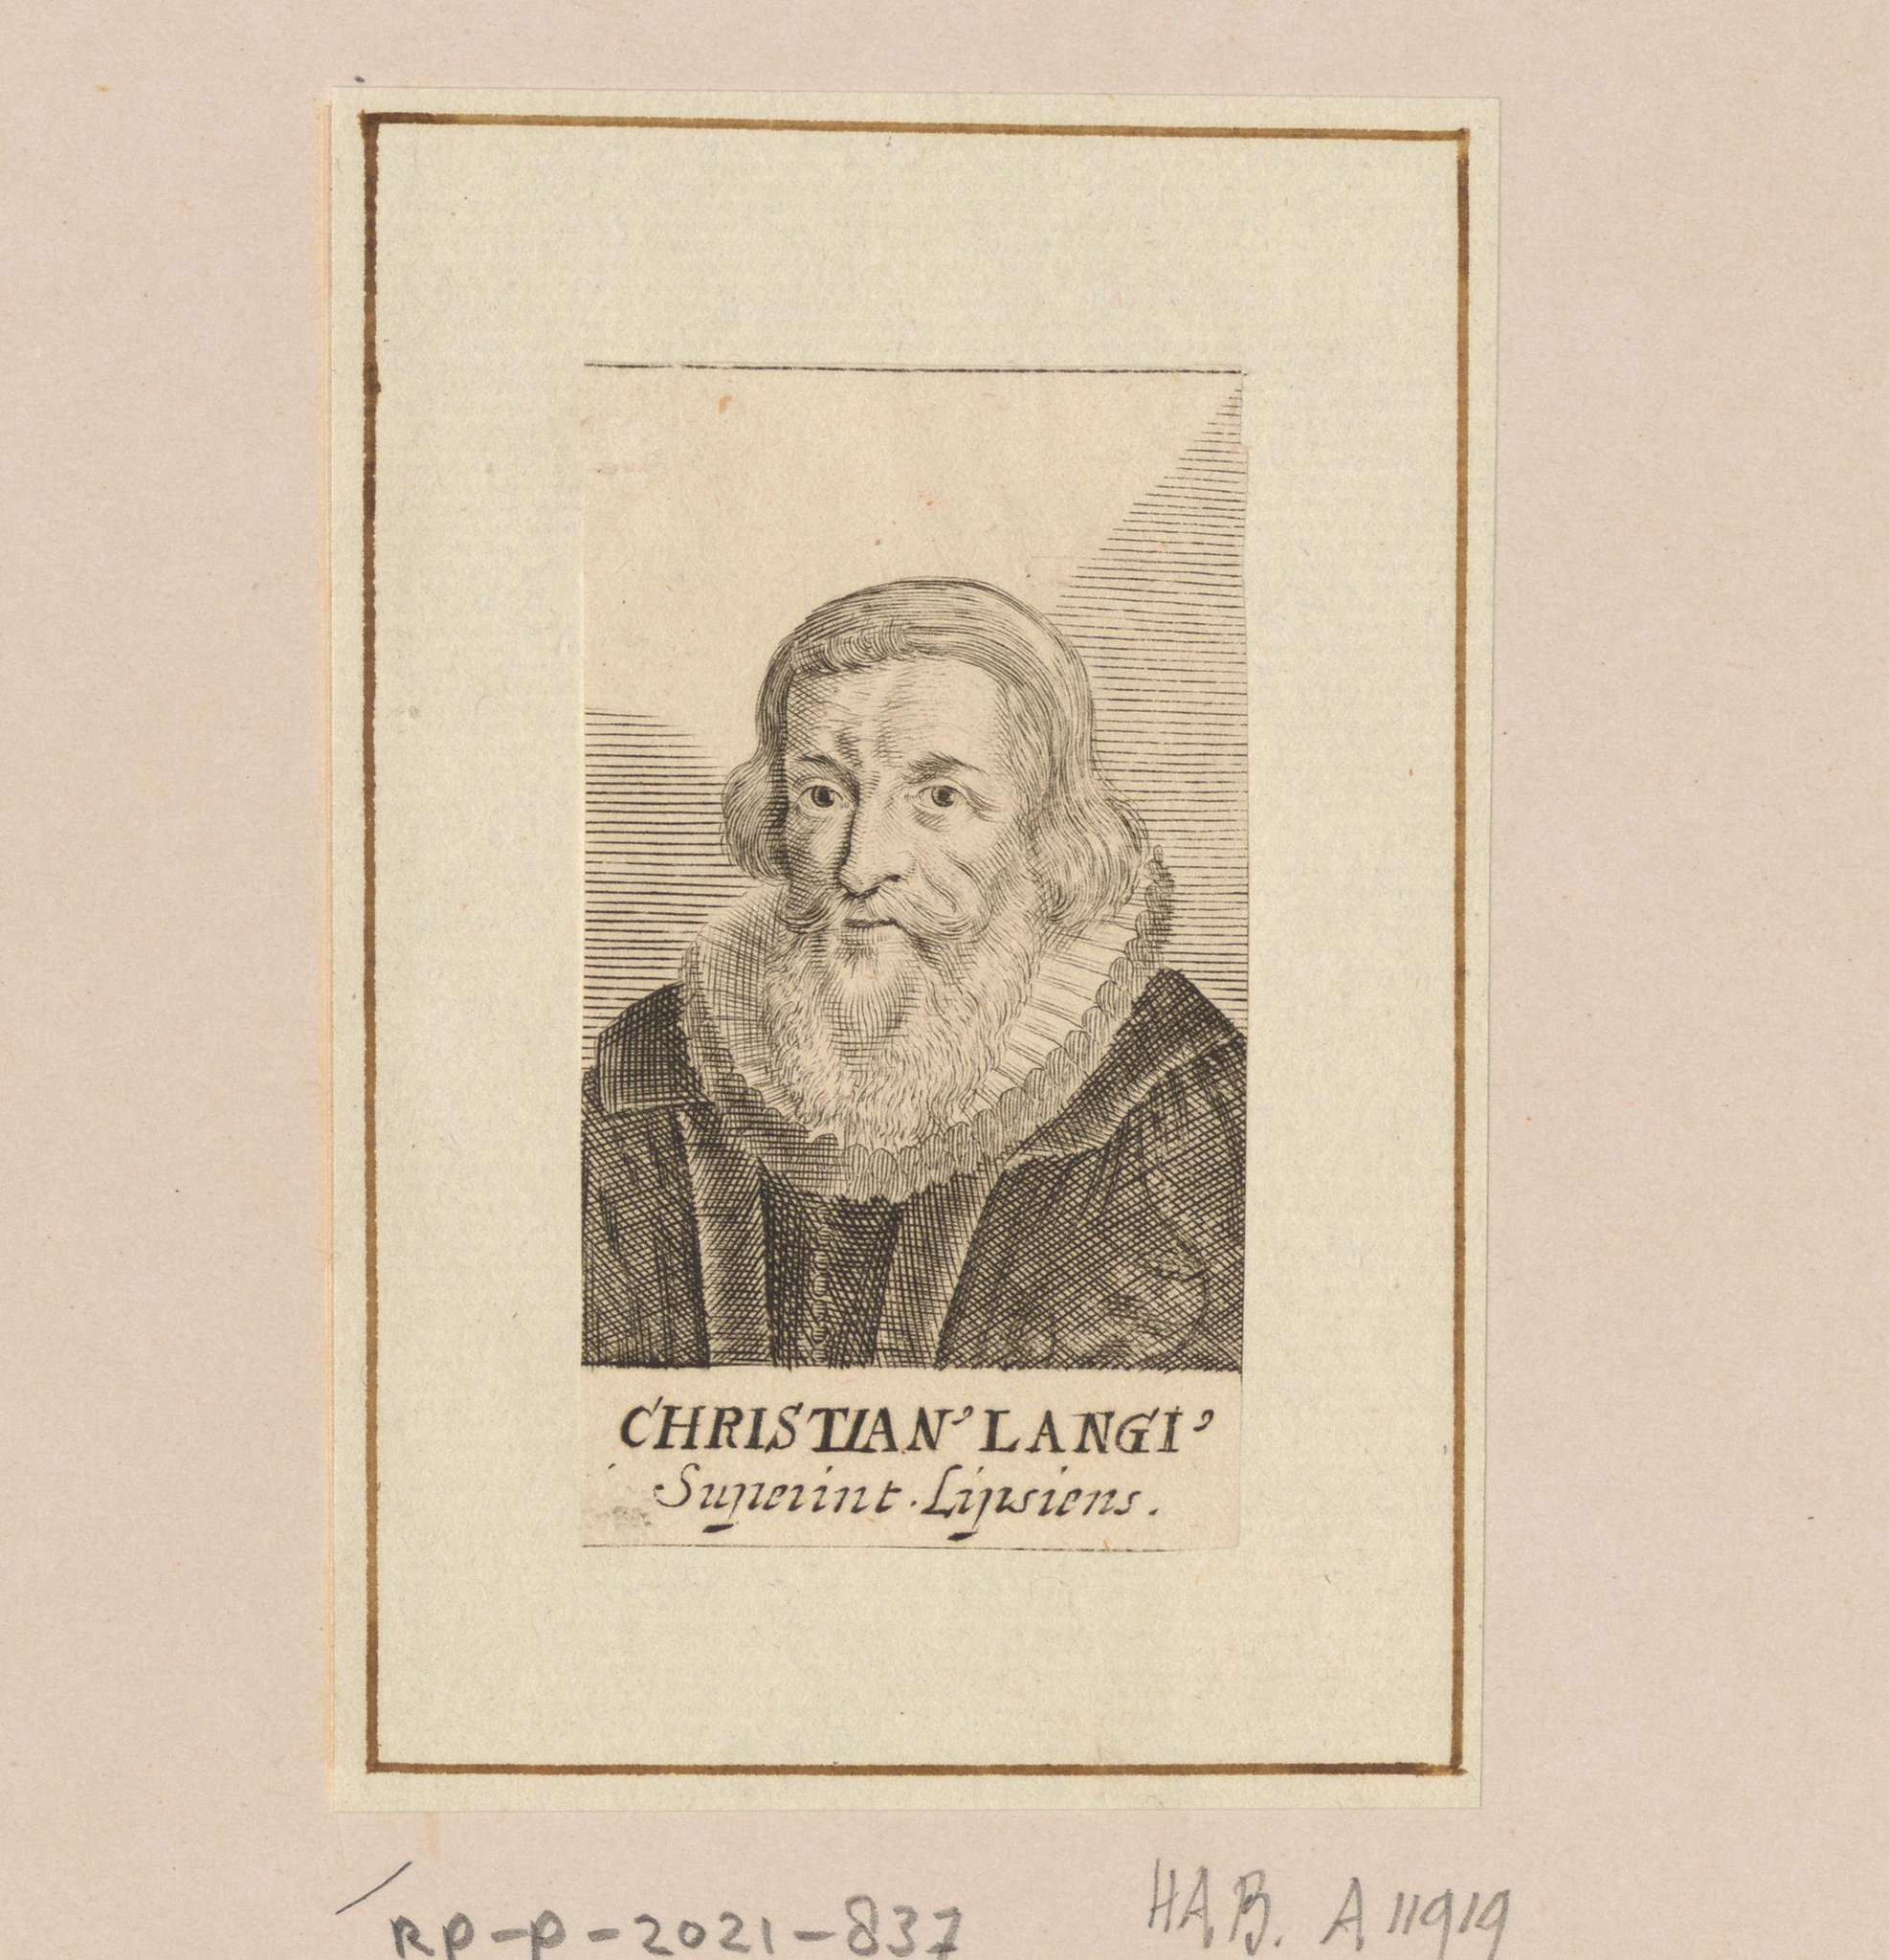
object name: book illustration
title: Portret van Christian Lange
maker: johann franck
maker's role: print maker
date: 1688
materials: paper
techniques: engraving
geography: germany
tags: theologian, historical persons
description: Prent waarschijnlijk uit: Freher, Paul. Theatrum virorum eruditione clarorum. Neurenberg: Johann Hoffmann, 1688.